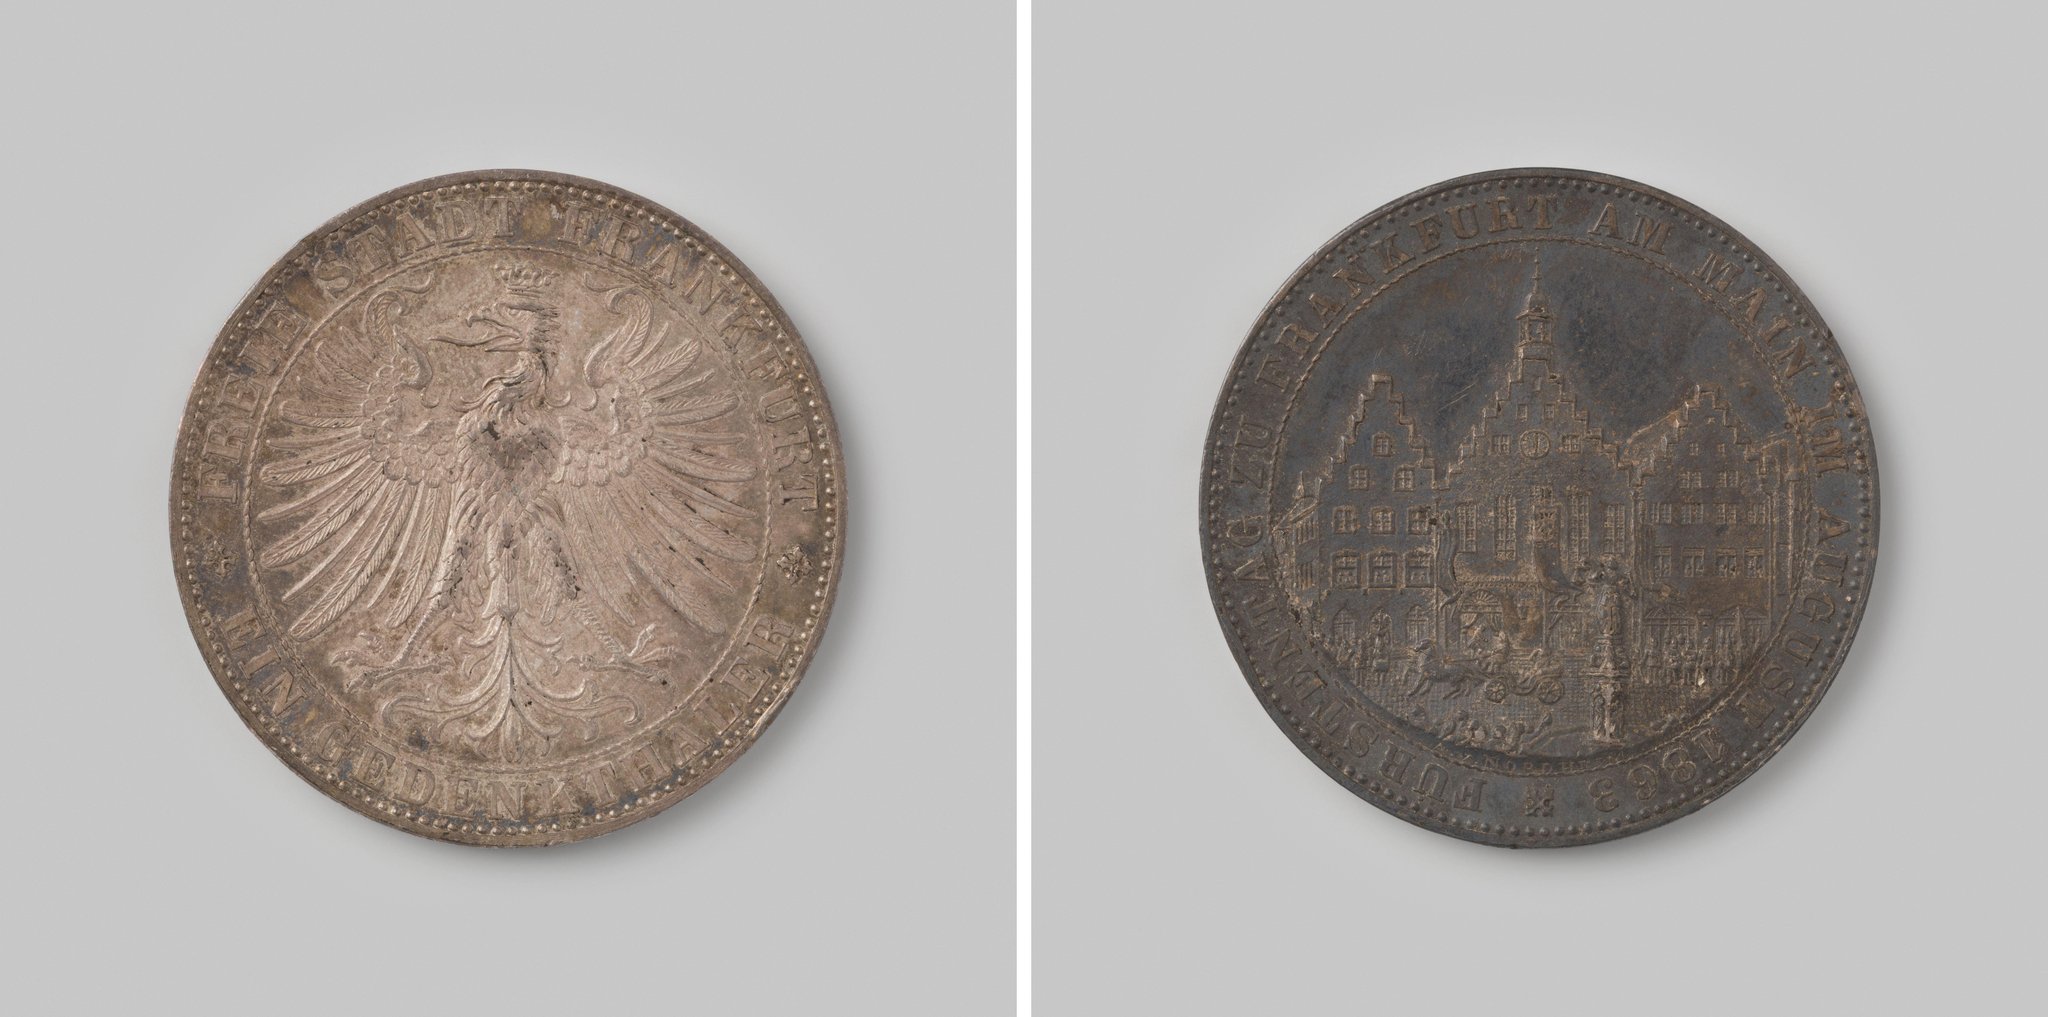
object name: herdenkingstaler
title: Vrije rijksstad Frankfurt am Main, gedenkthaler, 1863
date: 1863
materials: silver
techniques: striking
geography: frankfurt am main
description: Zilveren munt. Voorzijde: gekroonde enkelkoppige adelaar. Waarde-aanduiding EIN GEDENKTHALER in omschrift. Keerzijde: stadsgezicht met op de voorgrond zich verzamelende vorsten ter gelegenheid van de Fürstentag. In omschrift jaartal. Randschrift.